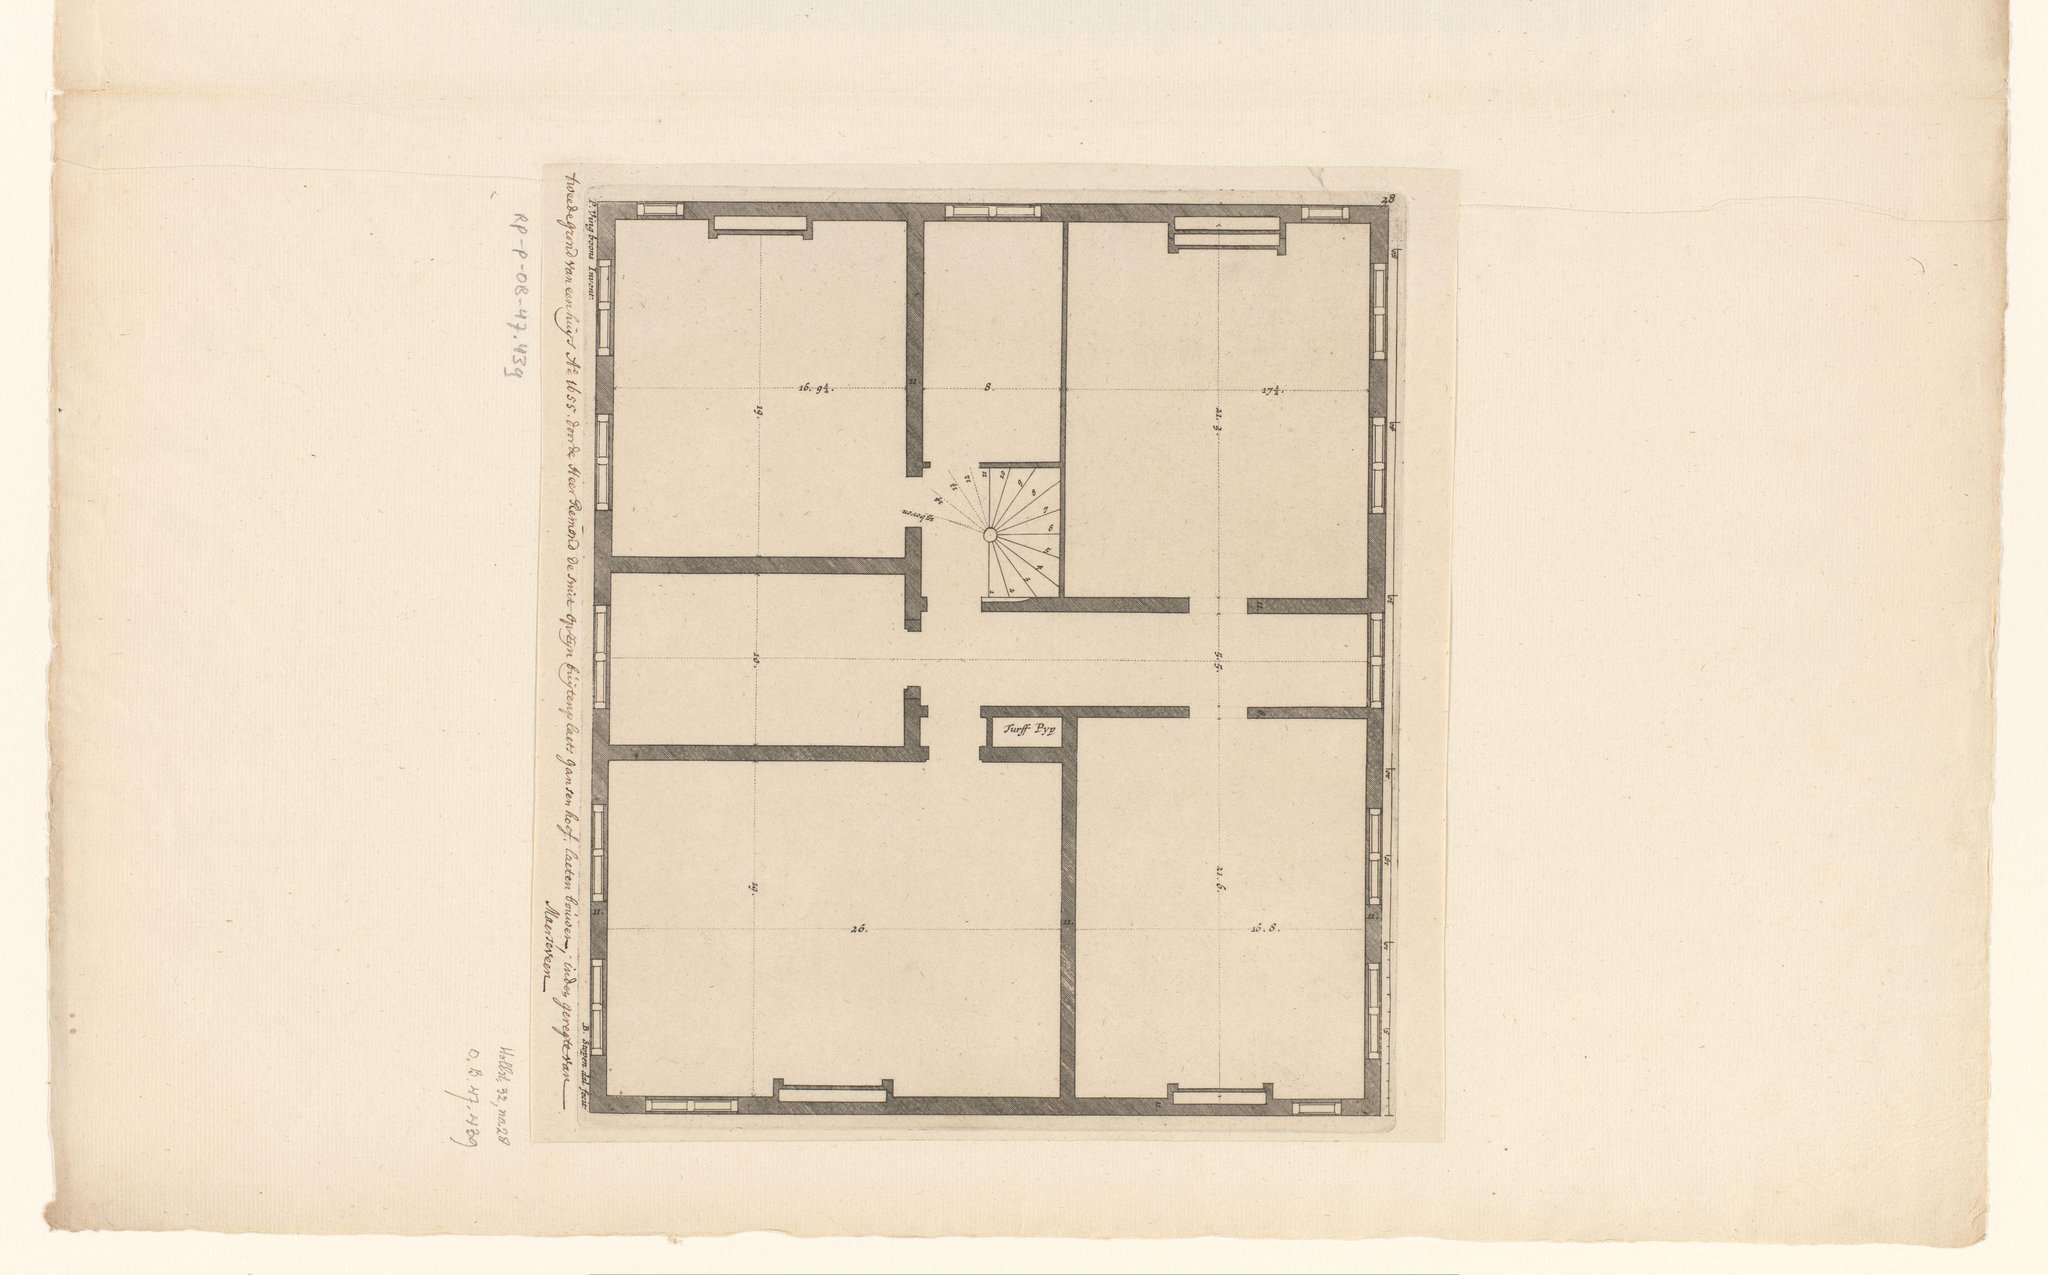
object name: book illustration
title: Plattegrond van de eerste verdieping van het huis Gansenhoef te Maarssen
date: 1715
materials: paper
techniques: etching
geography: amsterdam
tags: plan ~ architecture, country-house, maarssen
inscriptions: inscription: ‘tweede grond van een huijs Ao. 1655. door de Heer Remond de Smit op zijn buijtenplaets gansenhoef laeten bouwen, in den geregte van/ Maerseveen’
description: Prent waarschijnlijk uit: De gronden, afbeeldingen en beschryvingen der aldervoornaamste en aldernieuwste gebouwen uyt alle die door Philippus Vingboons (...). Leiden: Pieter van der Aa, 1715. De prent is waarschijnlijk in een eerdere staat gebruikt in publicaties uit 1674, 1687 en 1699. Deze prent is geplakt op een albumblad, dat vast zit aan een ander albumblad. Op het eerste albumblad is RP-P-OB-47.438 geplakt.